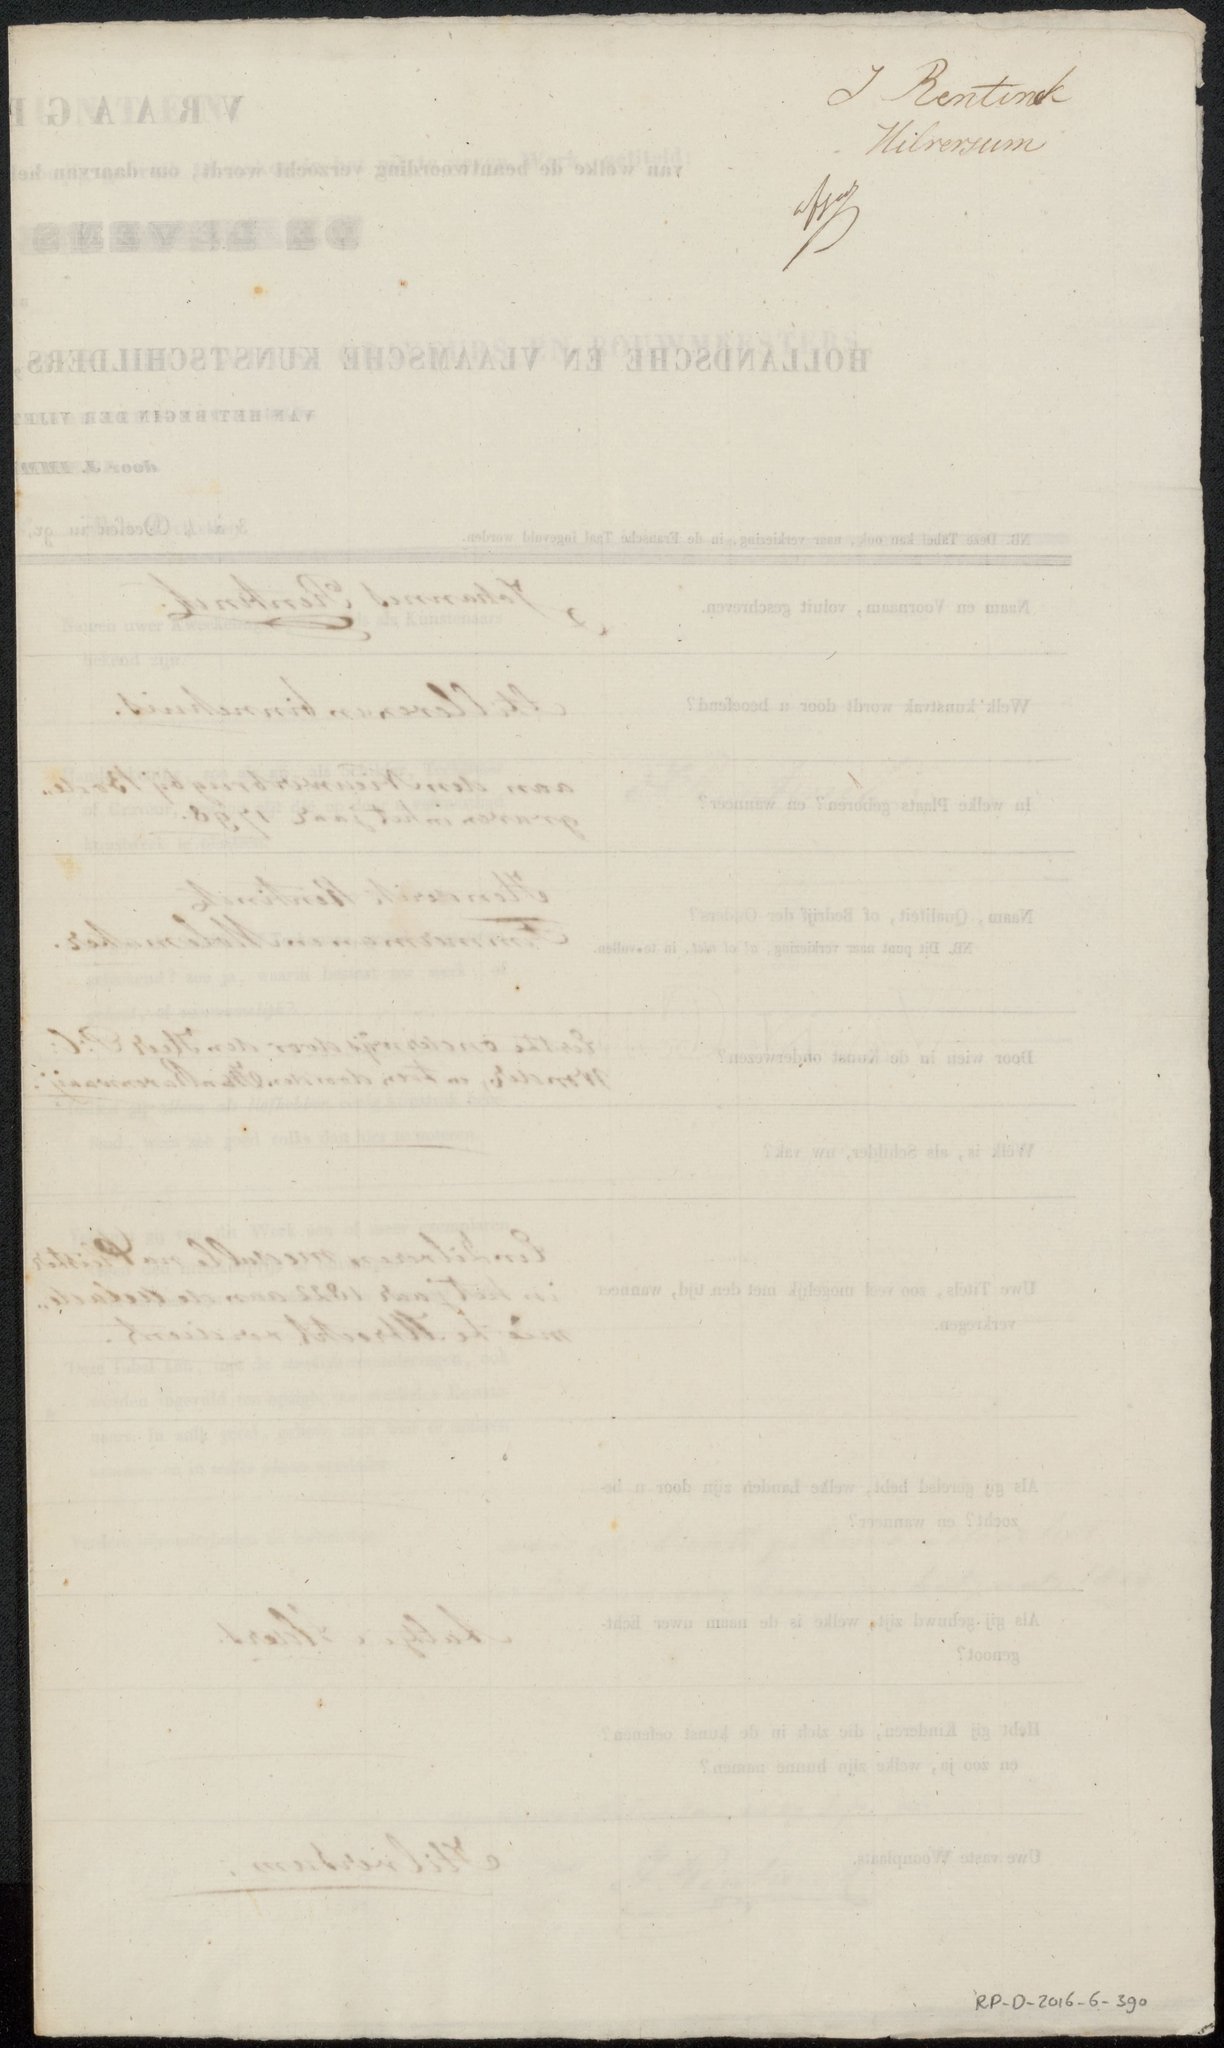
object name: questionnaire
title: Enquêteformulier ingevuld door Johannes Rentinck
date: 1841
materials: ink, paper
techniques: pen, printing, writing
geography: hilversum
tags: painter, johannes rentinck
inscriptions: inscription: ‘Vraagpunten,/ van welke de beantwoording verzocht wordt, om daarvan het noodig gebruik te maken in het uit te geven Werk, getiteld: De levens en werken/ der Hollandsche en Vlaamsche kunstschilders, beeldhouwers,/ graveurs en bouwmeesters, van het begin der vijftiende eeuw tot heden/ door J. Immerzeel, Jr.’, watermark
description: Opgenomen in: Immerzeel, J. Jr., De levens en werken der Hollandsche en Vlaamsche kunstschilders, beeldhouwers, graveurs en bouwmeesters, van het begin der vijftiende eeuw tot heden, Amsterdam: J.C. van Kesteren, 1842-1843.